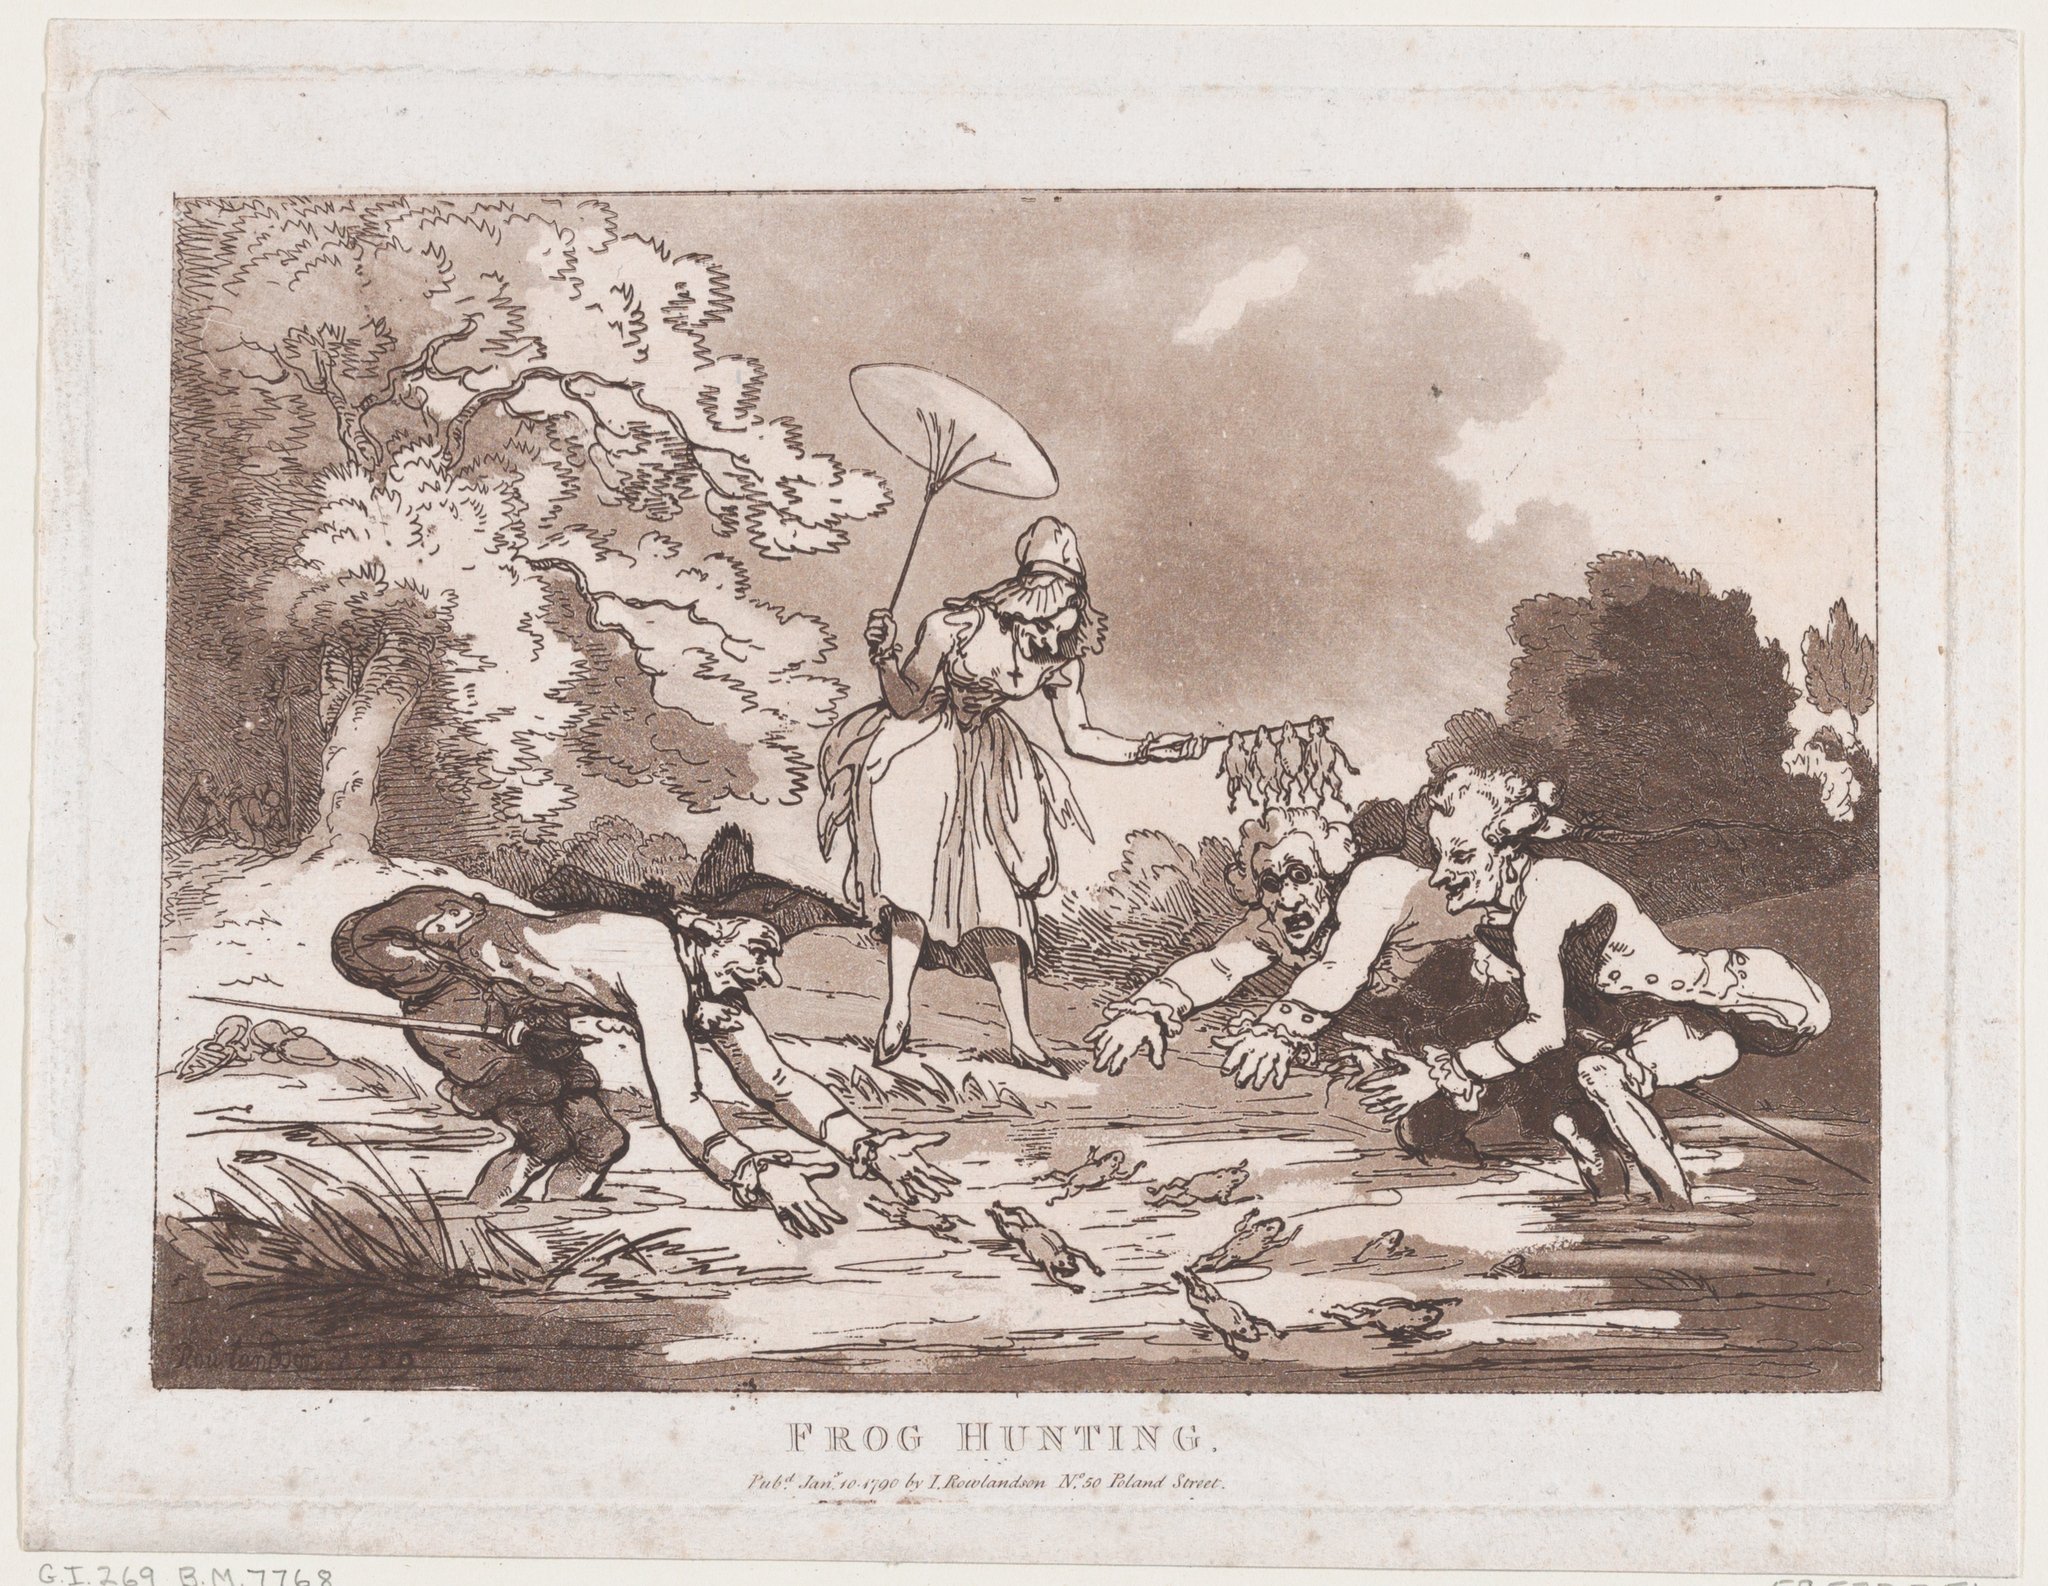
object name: print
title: Frog Hunting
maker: thomas rowlandson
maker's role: artist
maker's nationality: british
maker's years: 1757-1827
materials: ink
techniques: aquatint, etching, printing